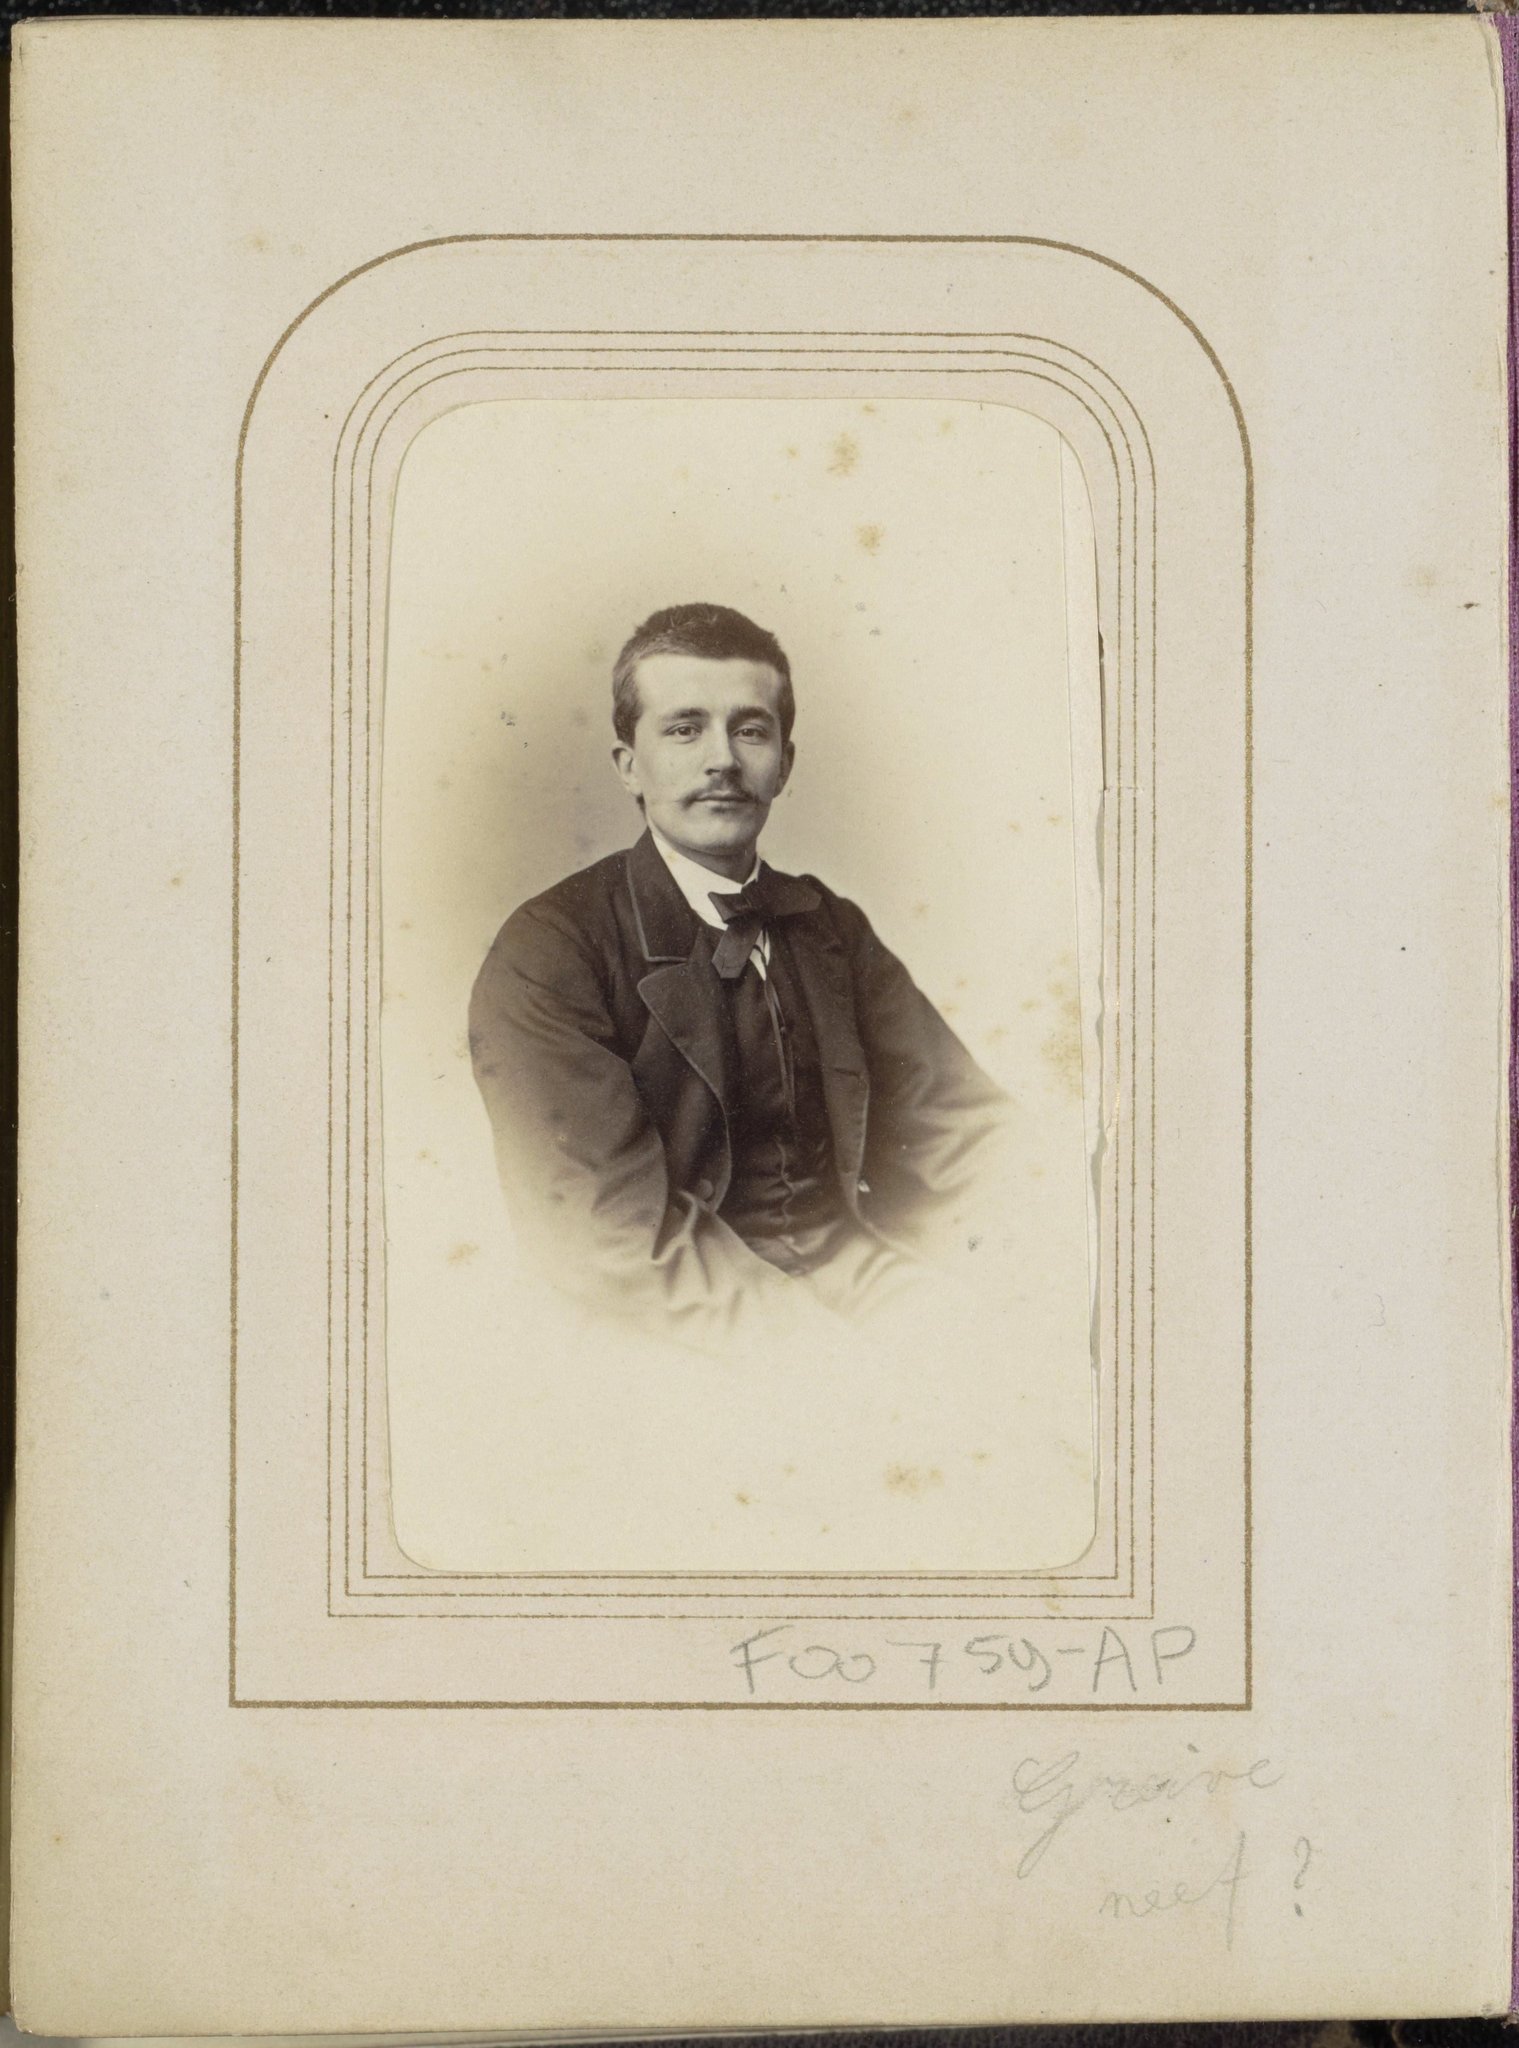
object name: photograph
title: Portret van Johan Conrad Greive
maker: matthijs adolph conen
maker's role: painter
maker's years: 1833-1894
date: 1862-1885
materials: cardboard, paper, photographic support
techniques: albumen print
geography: amsterdam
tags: print maker, draughtsman, johan conrad greive, moustache, historical persons, neck-gear ~ clothing, clothing for the upper part of the body, amsterdam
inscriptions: inscription: ‘Greive neef?’, address: ‘Amsterdam, Plantage, Middenlaan et Kerklaan V132’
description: Onderdeel van Fotoalbum van een Nederlandse familie met 50 cartes-de-visite.